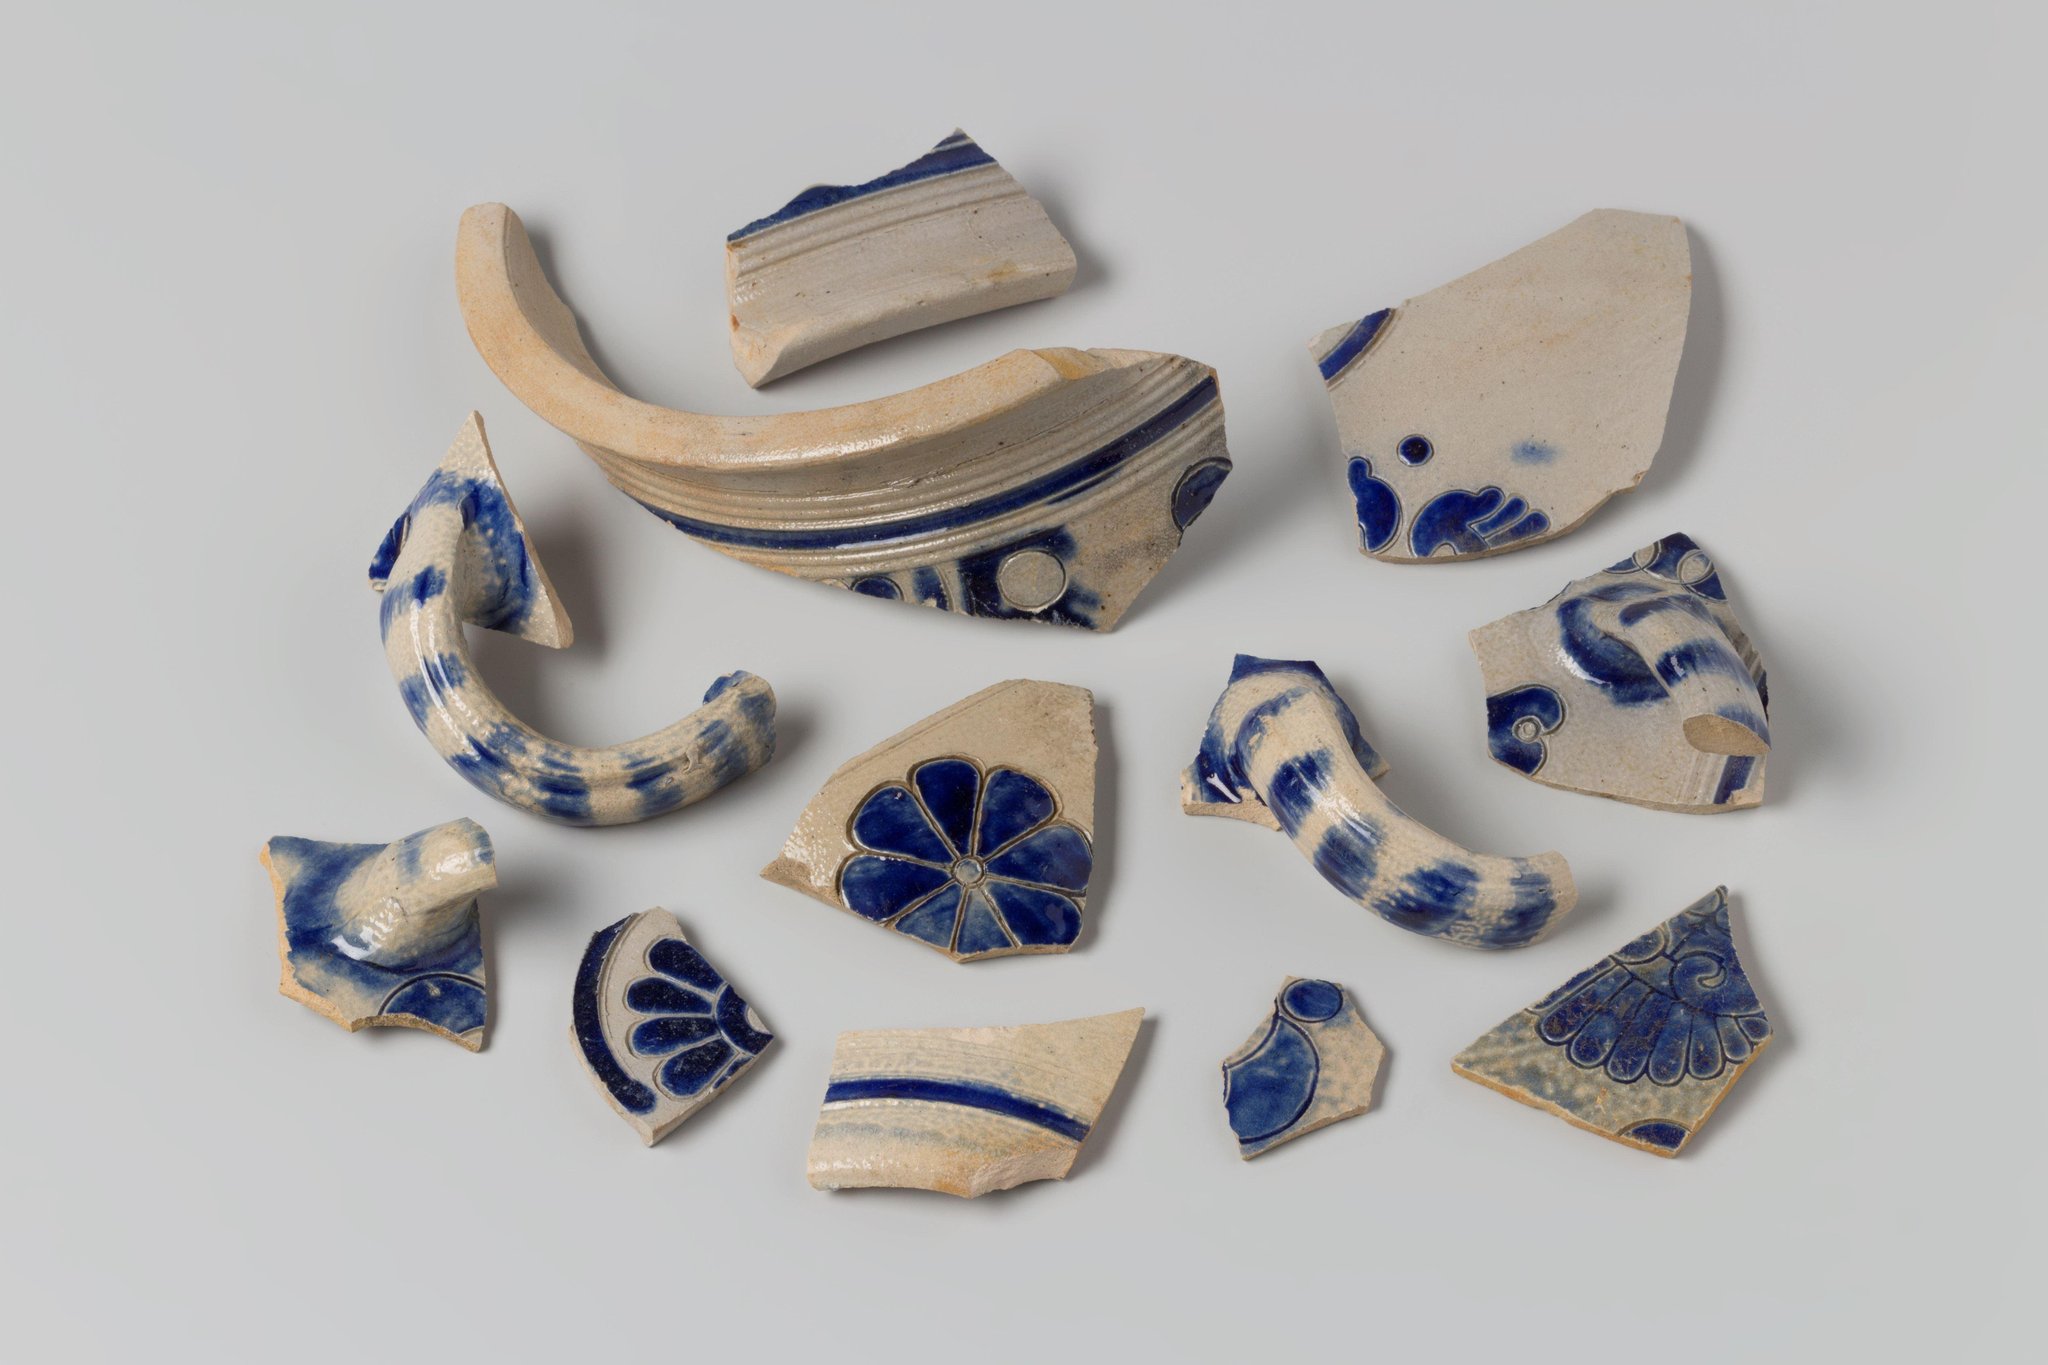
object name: pot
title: Scherven van potten uit het wrak van de Oost-Indiëvaarder Hollandia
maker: Anonymous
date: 1700-1743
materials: stoneware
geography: westerwald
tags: verenigde oostindische compagnie, hollandia (schip), annet